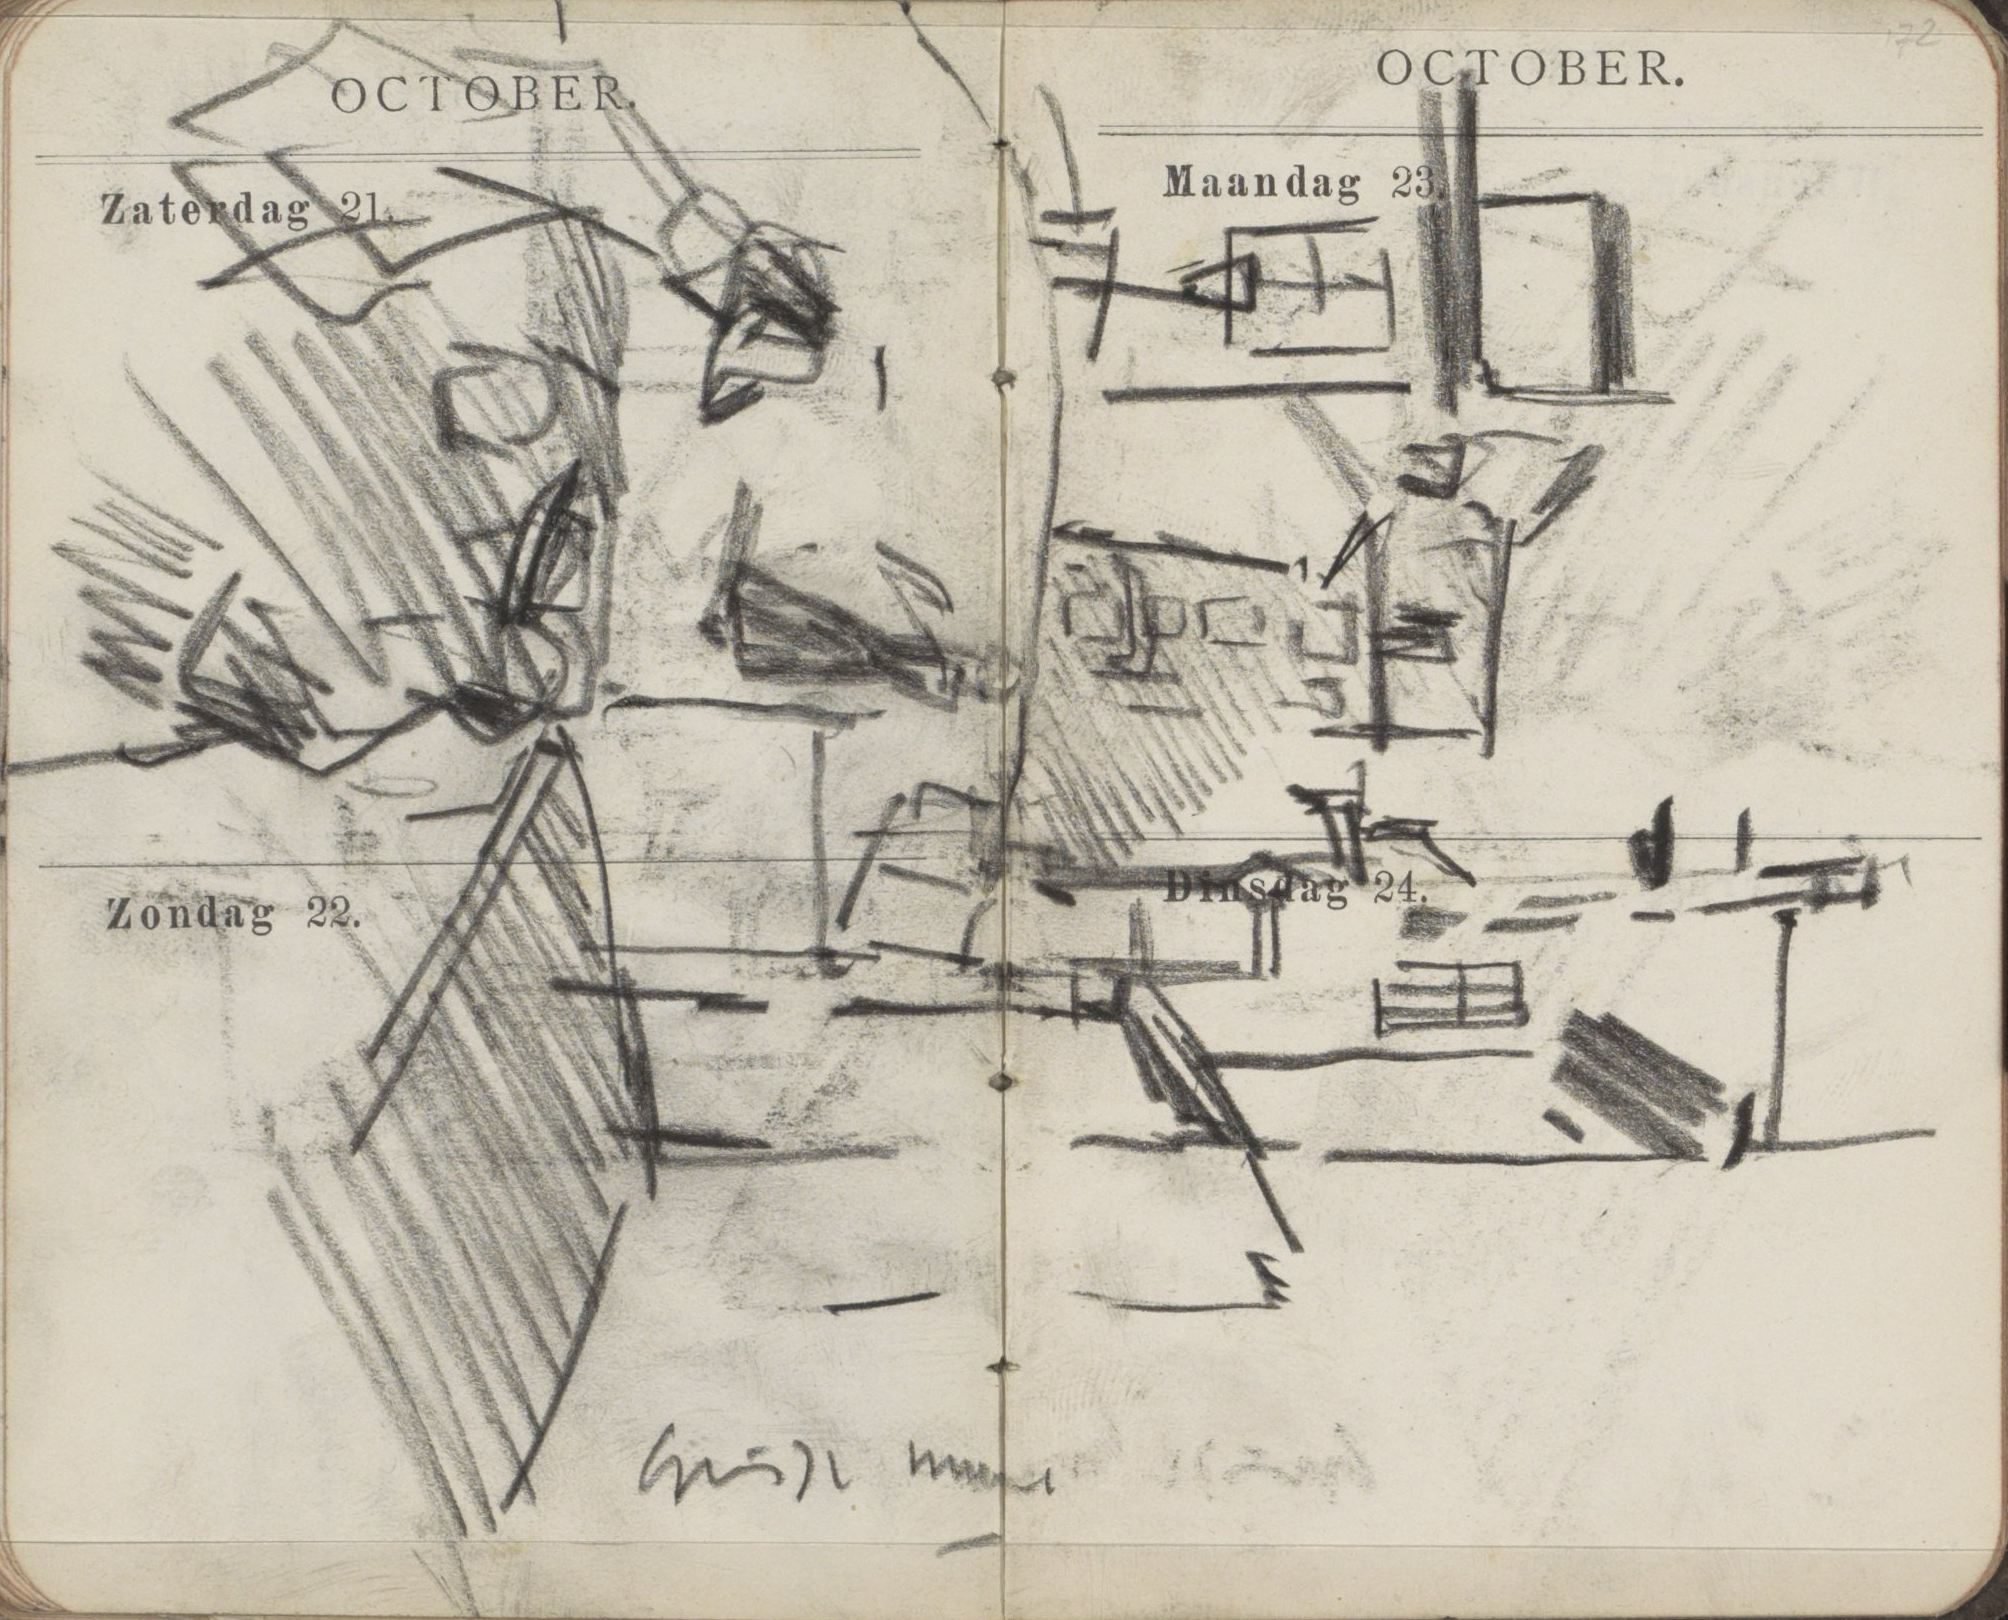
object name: sketchbook leaf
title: Gezicht op een straat in Amsterdam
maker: george hendrik breitner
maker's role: draughtsman, painter, print maker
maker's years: 1857-1923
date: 1893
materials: chalk, paper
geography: amsterdam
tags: bridge in city across river, canal, etc., civic architecture; edifices; dwellings, street (+ city(-scape) with figures, staffage), amsterdam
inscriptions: annotation: ‘grijs weer’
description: In het midden mogelijk een brug. Vooraan figuren. Pagina 171 en pagina 172 uit een als schetsboek gebruikte agenda met 108 bladen.